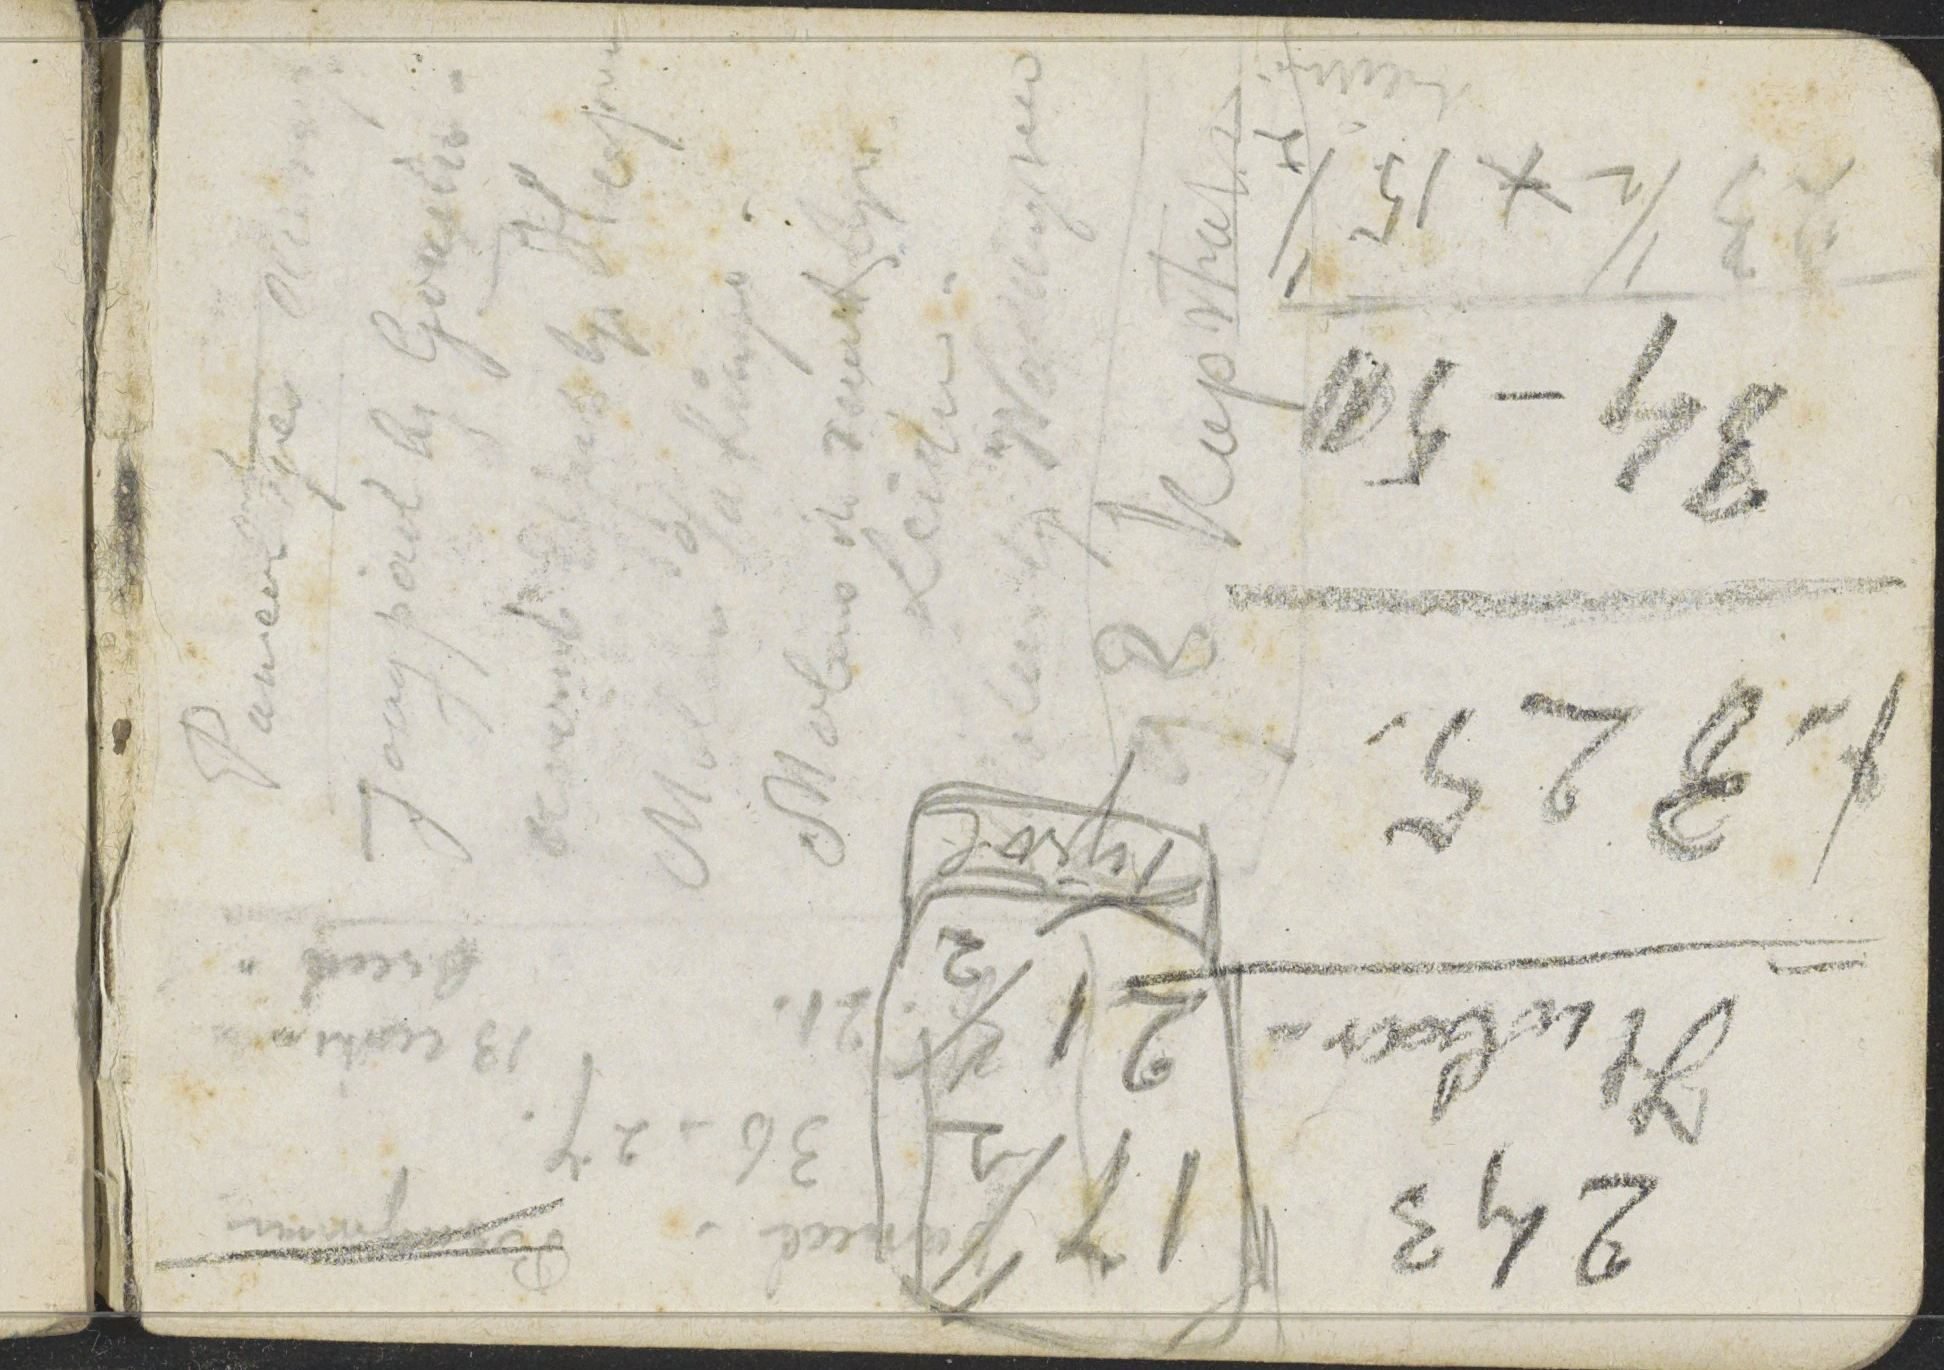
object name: endleaf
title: Notities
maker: willem cornelis rip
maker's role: draughtsman, painter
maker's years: 1856-1922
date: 1907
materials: chalk, paper, pencil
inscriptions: annotation: ‘Paneeltjes [...]/ Jaagpad bij Gouda-/ avond Effect bij He[...]/ Molen [...]hinge/ [...]’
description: Achterste schutblad uit een schetsboek met 41 bladen.